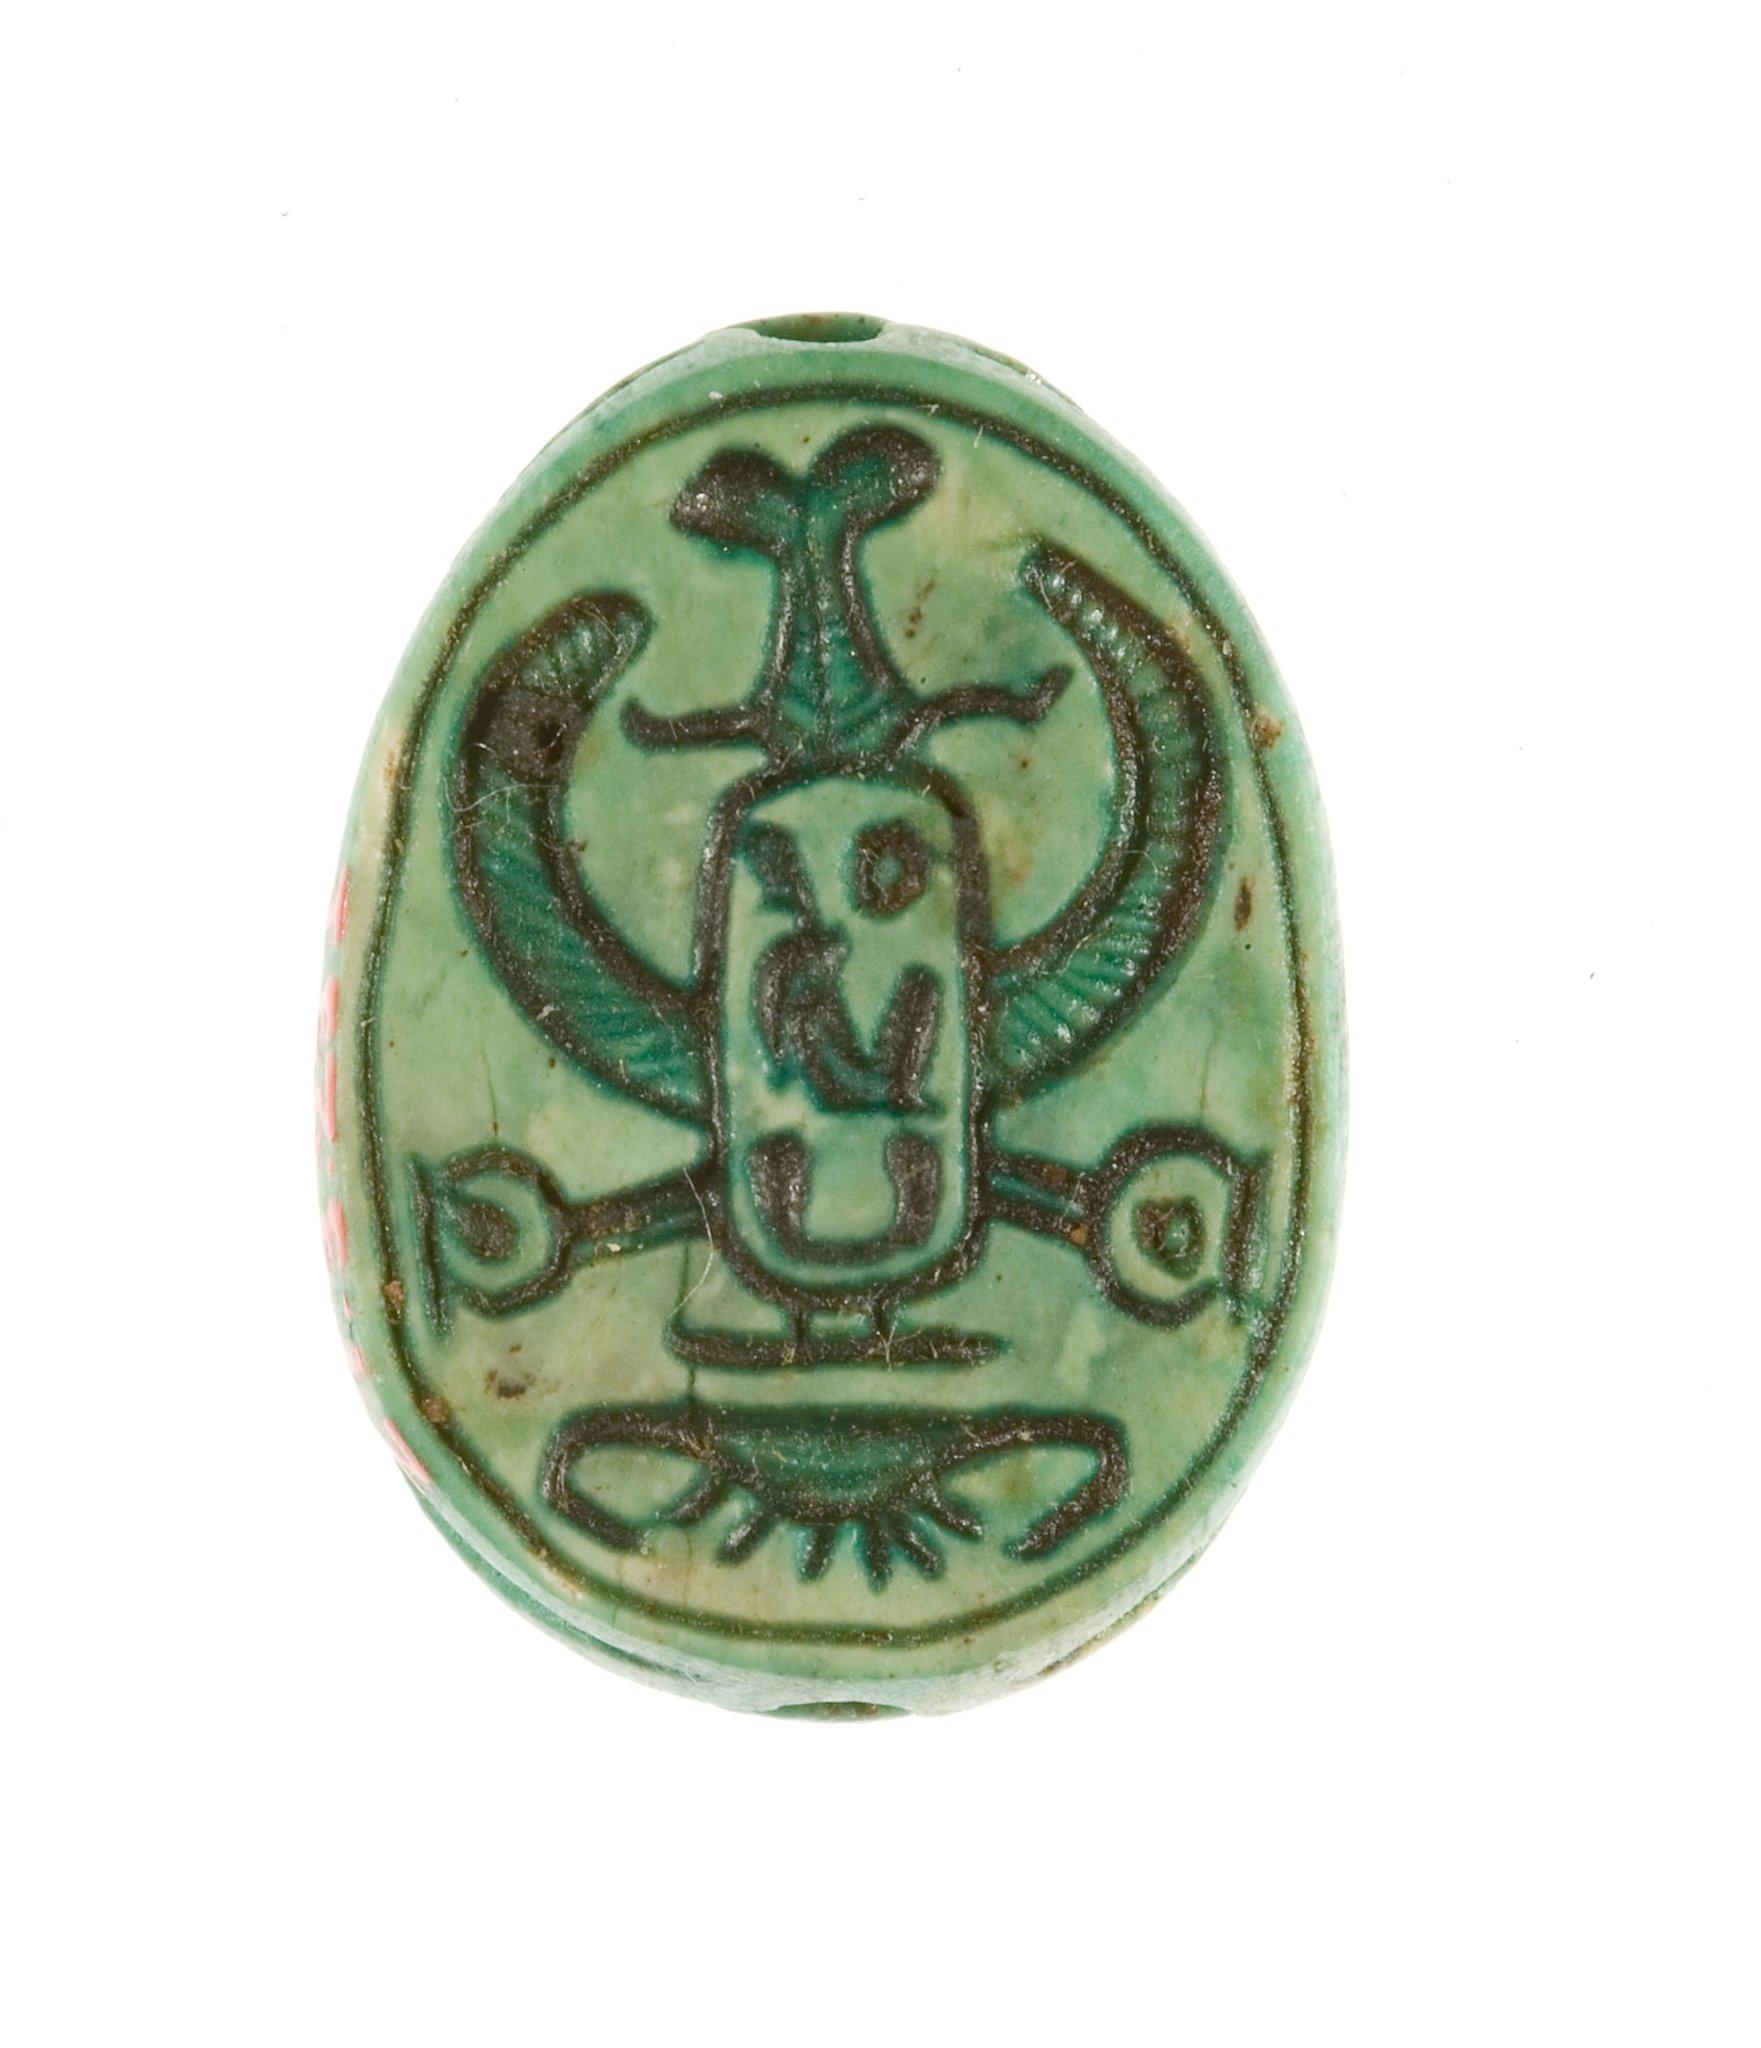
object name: scarab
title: Scarab Inscribed for Maatkare (Hatshepsut)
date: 1479-1458 BCE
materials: stone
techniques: glazing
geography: egypt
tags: hieroglyphs,scarabs